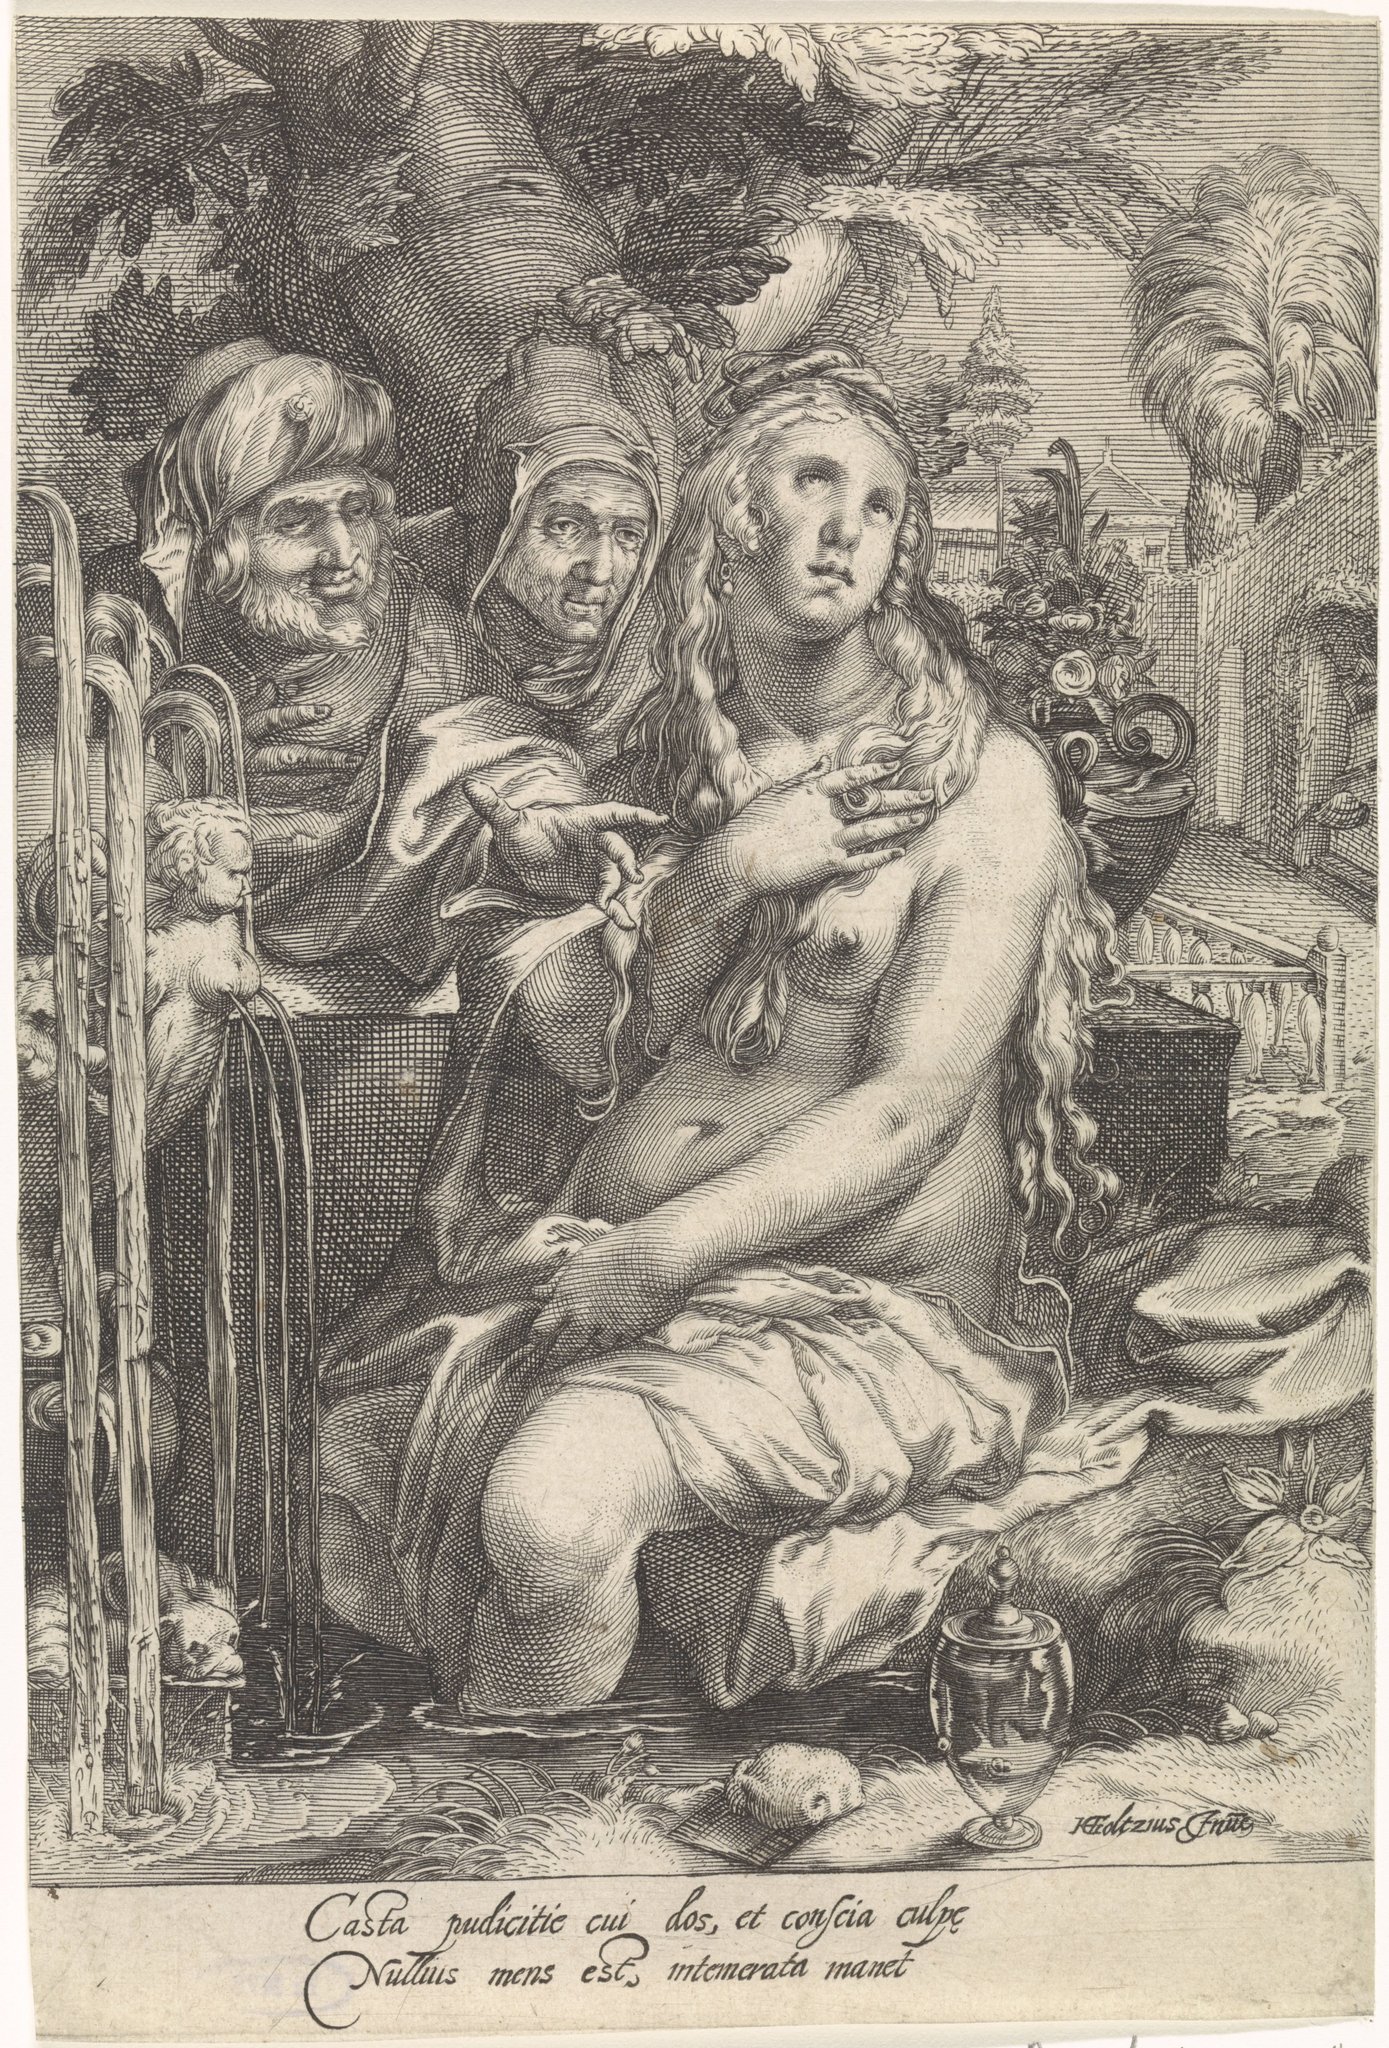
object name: print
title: Susanna en de ouderlingen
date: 1575-1657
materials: paper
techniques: engraving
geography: northern netherlands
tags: the elders spying upon susanna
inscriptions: signature: ‘H.Goltzius Inv.’, caption: ‘Casta pudicitie cui dos, et conscia culpe / Nullius mens est, intemerata manet.’, collector's mark: Lugt 2228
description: De half-naakte Susanna zit aan de rand van het bad bij een fontein. Twee ouderlingen begluren haar tijdens het baden en spreken haar aan. De prent heeft een Latijns onderschrift.